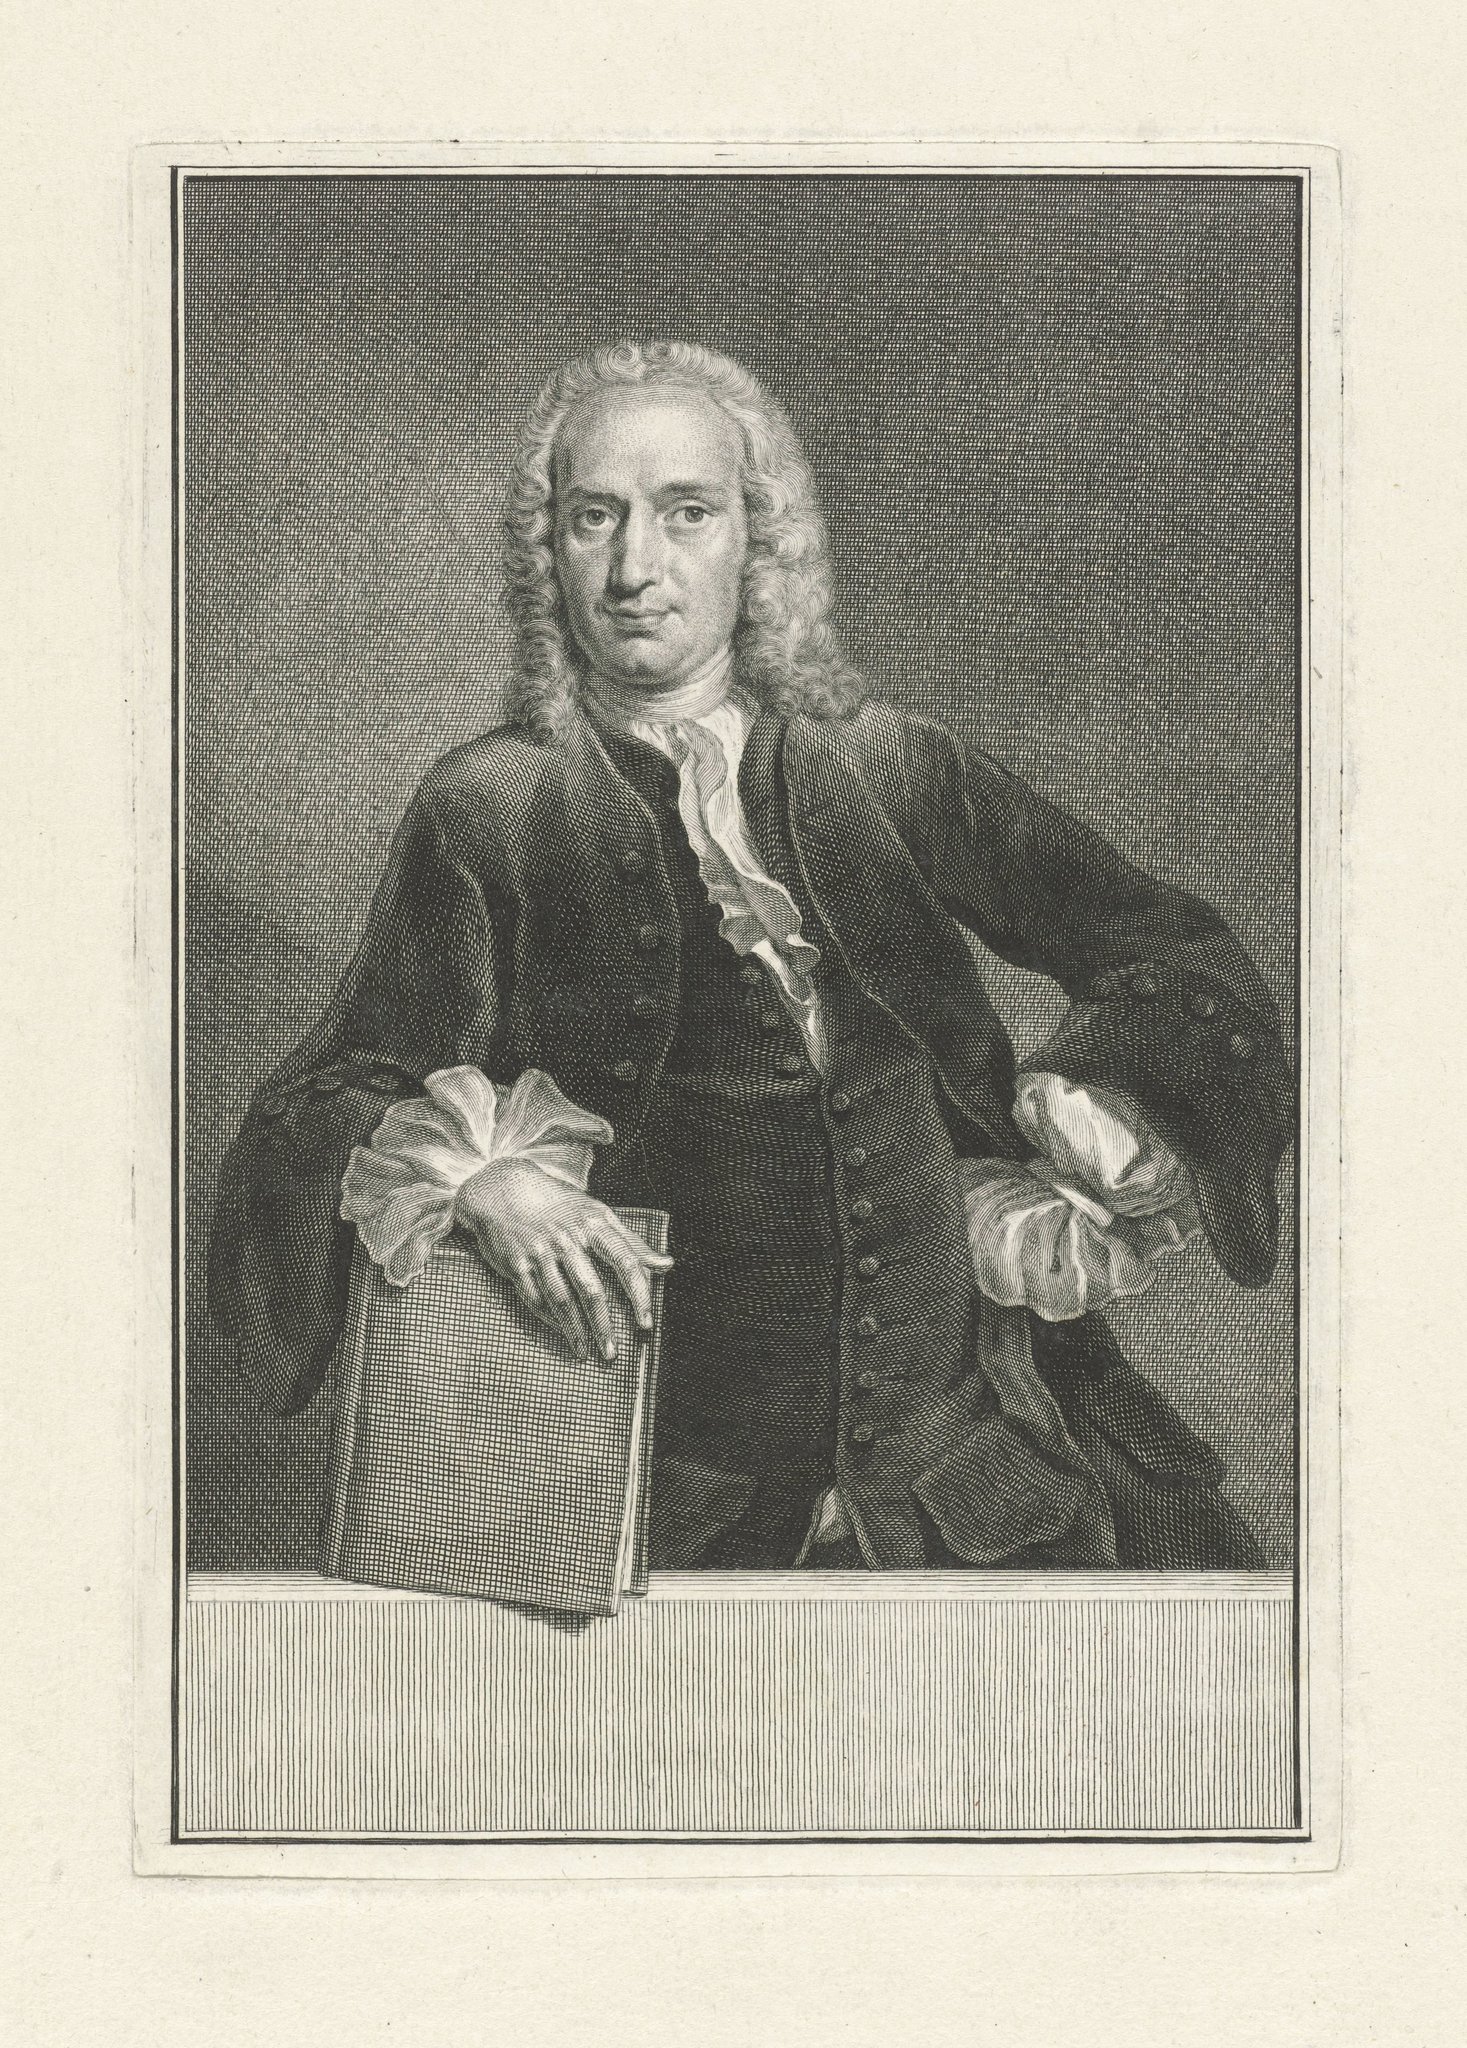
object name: print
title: Portret van Hubertus Gregorius van Vrijhoff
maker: jacob houbraken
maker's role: draughtsman, print maker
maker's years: 1698-1780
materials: paper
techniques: engraving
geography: amsterdam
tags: amsterdam, historical persons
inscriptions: collector's mark: Lugt 240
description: Portret van hoogleraar Rechten aan het Athenaeum Illustre (de voorloper van de Universiteit van Amsterdam) Hubertus Gregorius van Vrijhoff, zijn arm rustende op een boek op een plint voor hem.